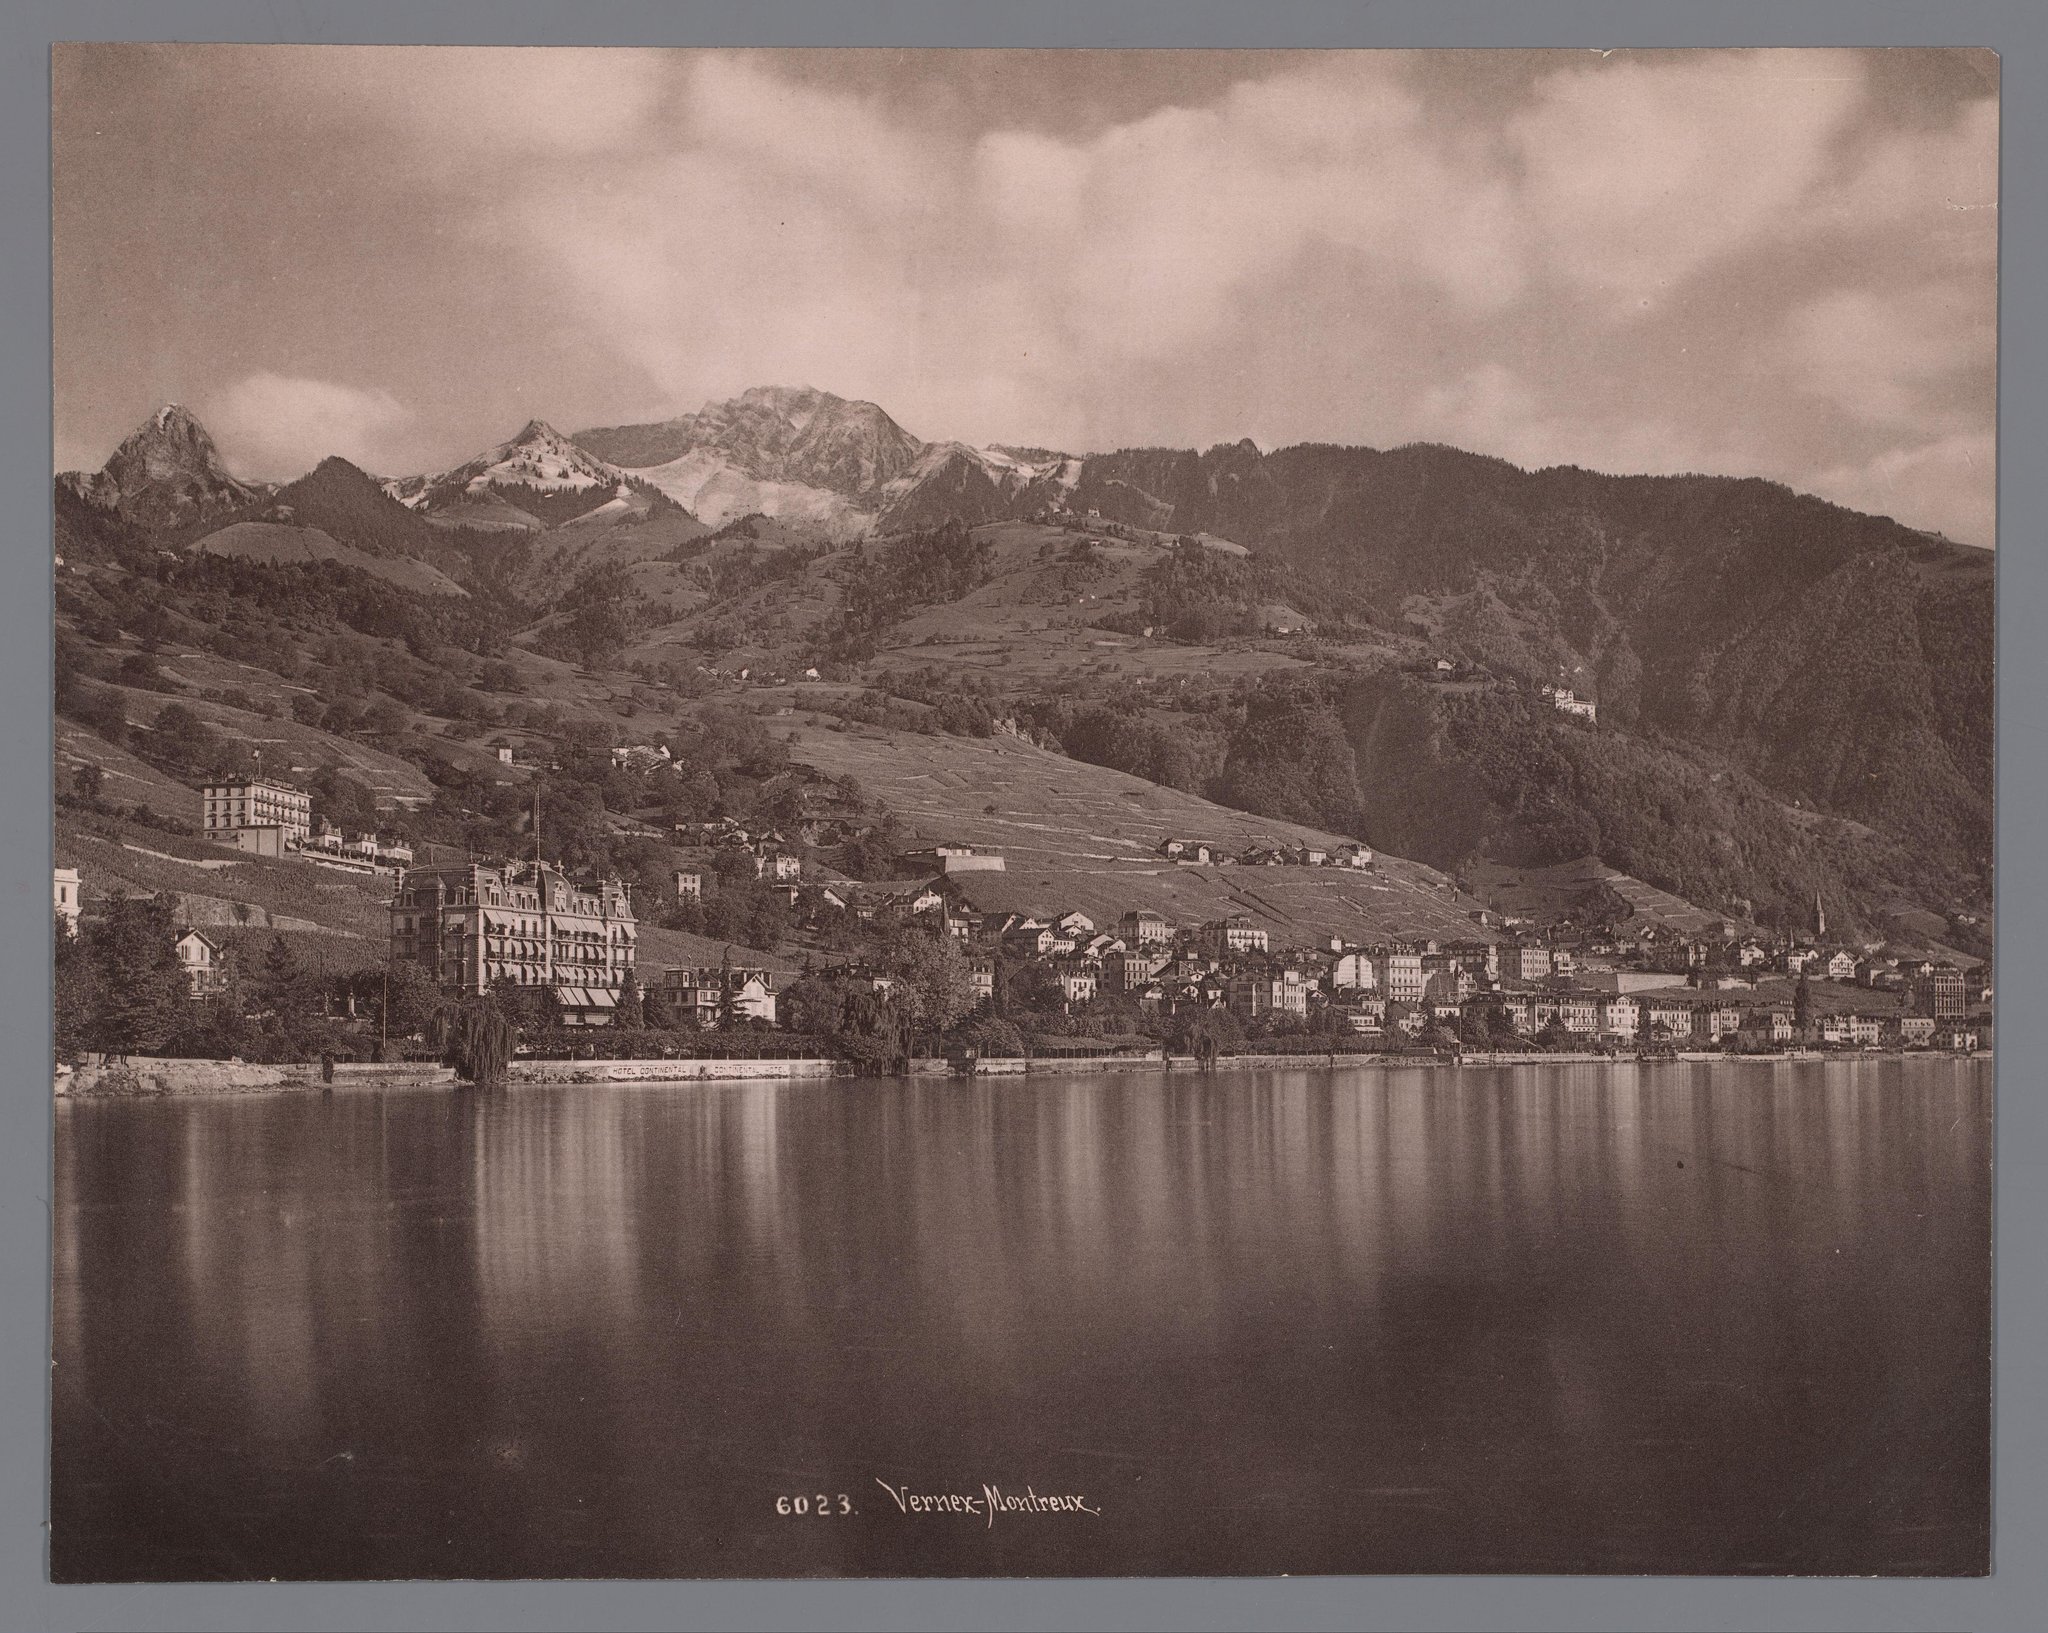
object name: photograph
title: Vernex-Montreux, kanton Vaud, Zwitserland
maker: Anonymous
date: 1890-1915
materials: paper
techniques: photograph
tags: montreux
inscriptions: inscription: ‘6023. Vernex-Montreux’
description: Montreux is een stad in het kanton Vaud in Zwitserland. Het ligt aan het Meer van Genève (frans: Lac Léman).